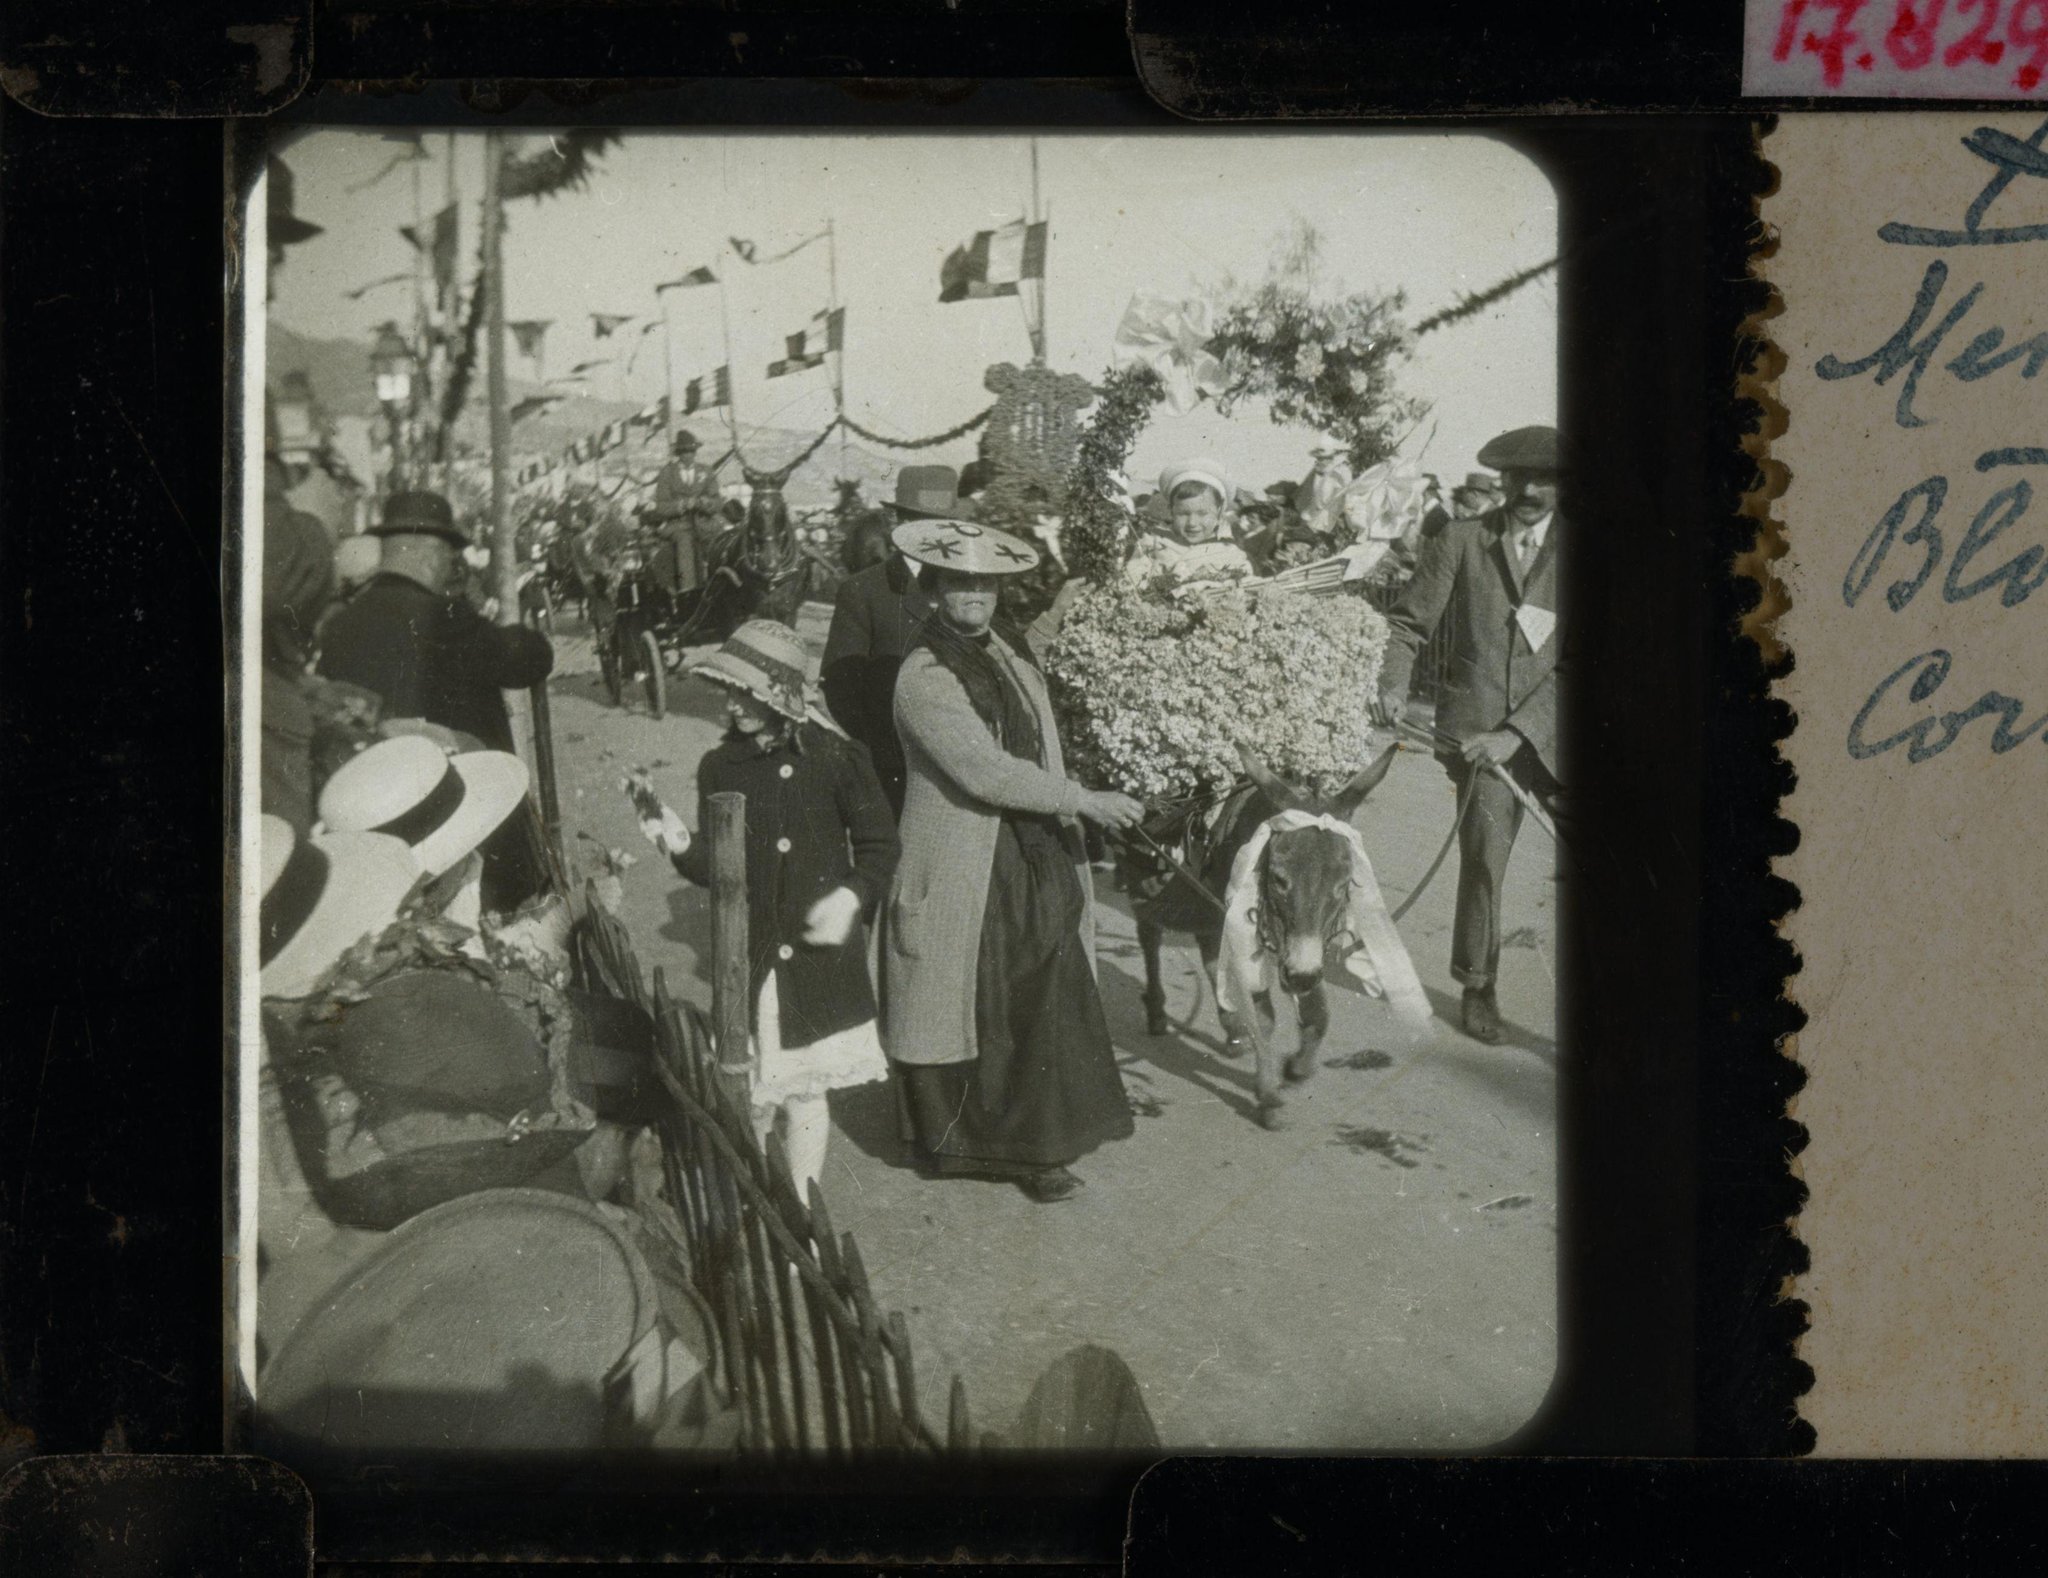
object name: album leaf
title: Menton - Bloemen Corso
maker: Anonymous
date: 1920-1925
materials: glass, metal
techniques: slide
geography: menton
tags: flowers, public festivities